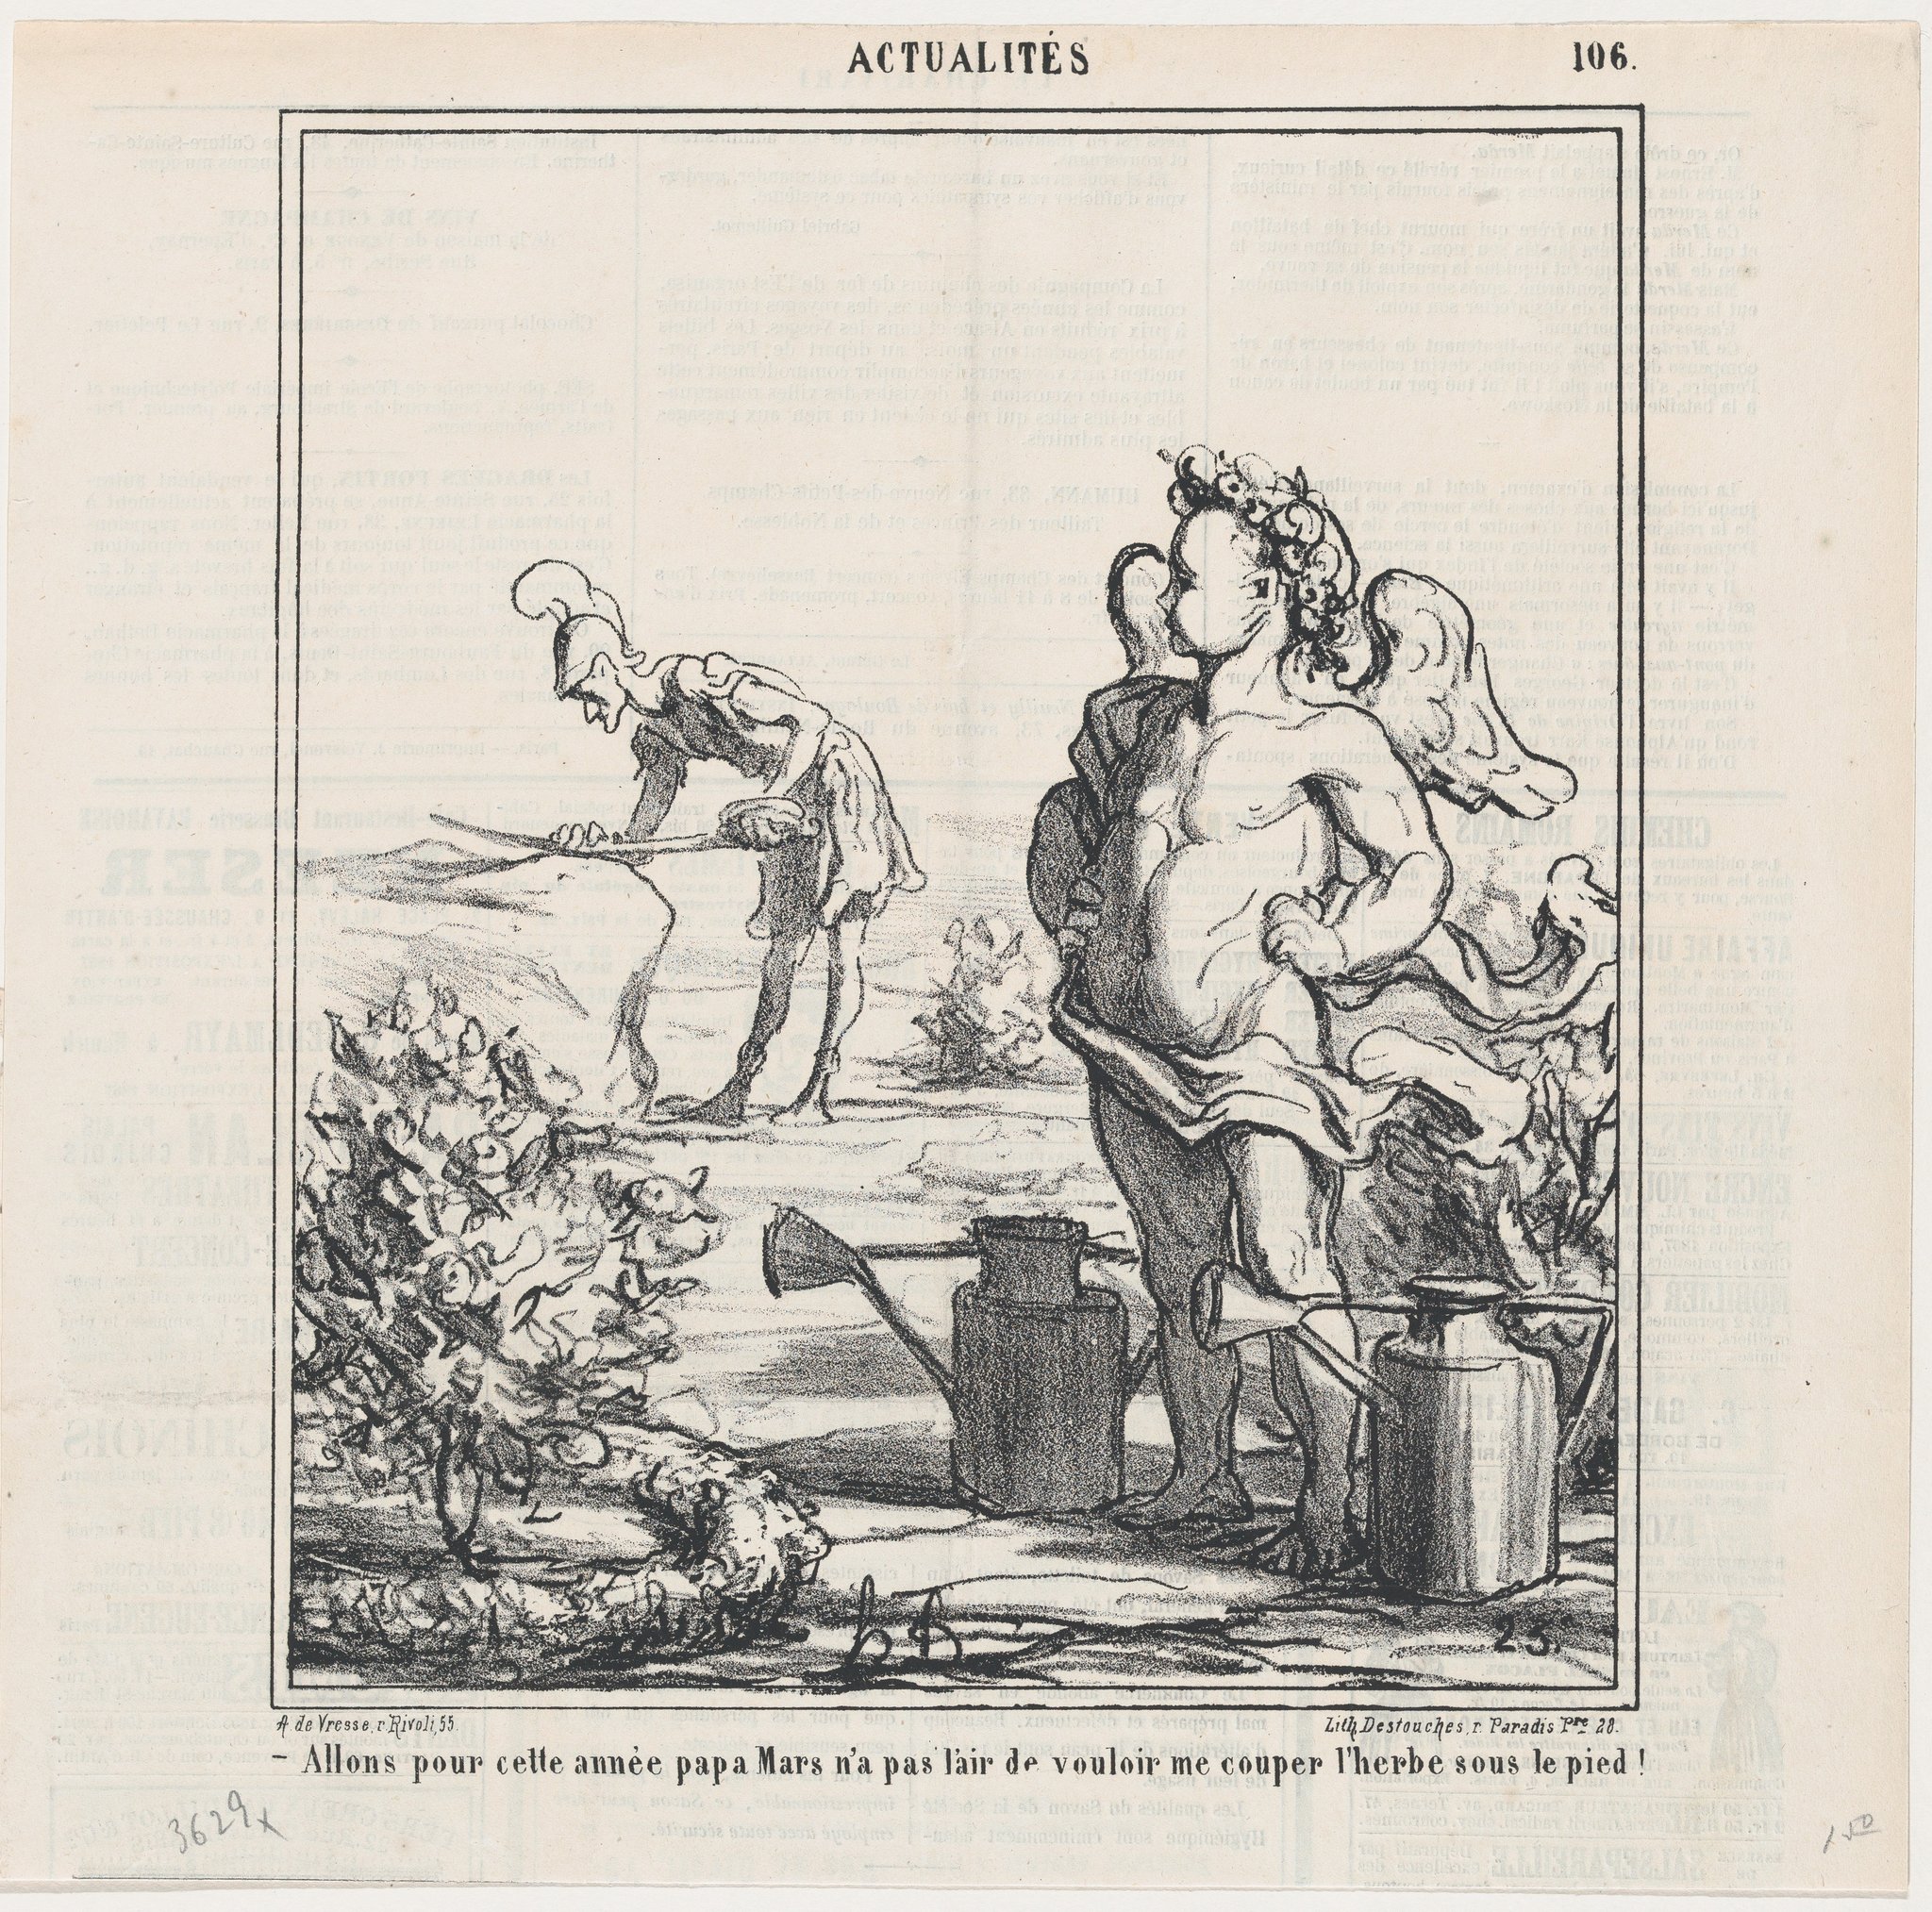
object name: print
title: It almost looks as if this year Papa Mars will not be cutting the grass under my feet, from "News of the day"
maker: honoré daumier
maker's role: artist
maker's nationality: french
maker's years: 1808-1879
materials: paper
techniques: lithograph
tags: swords,men,working